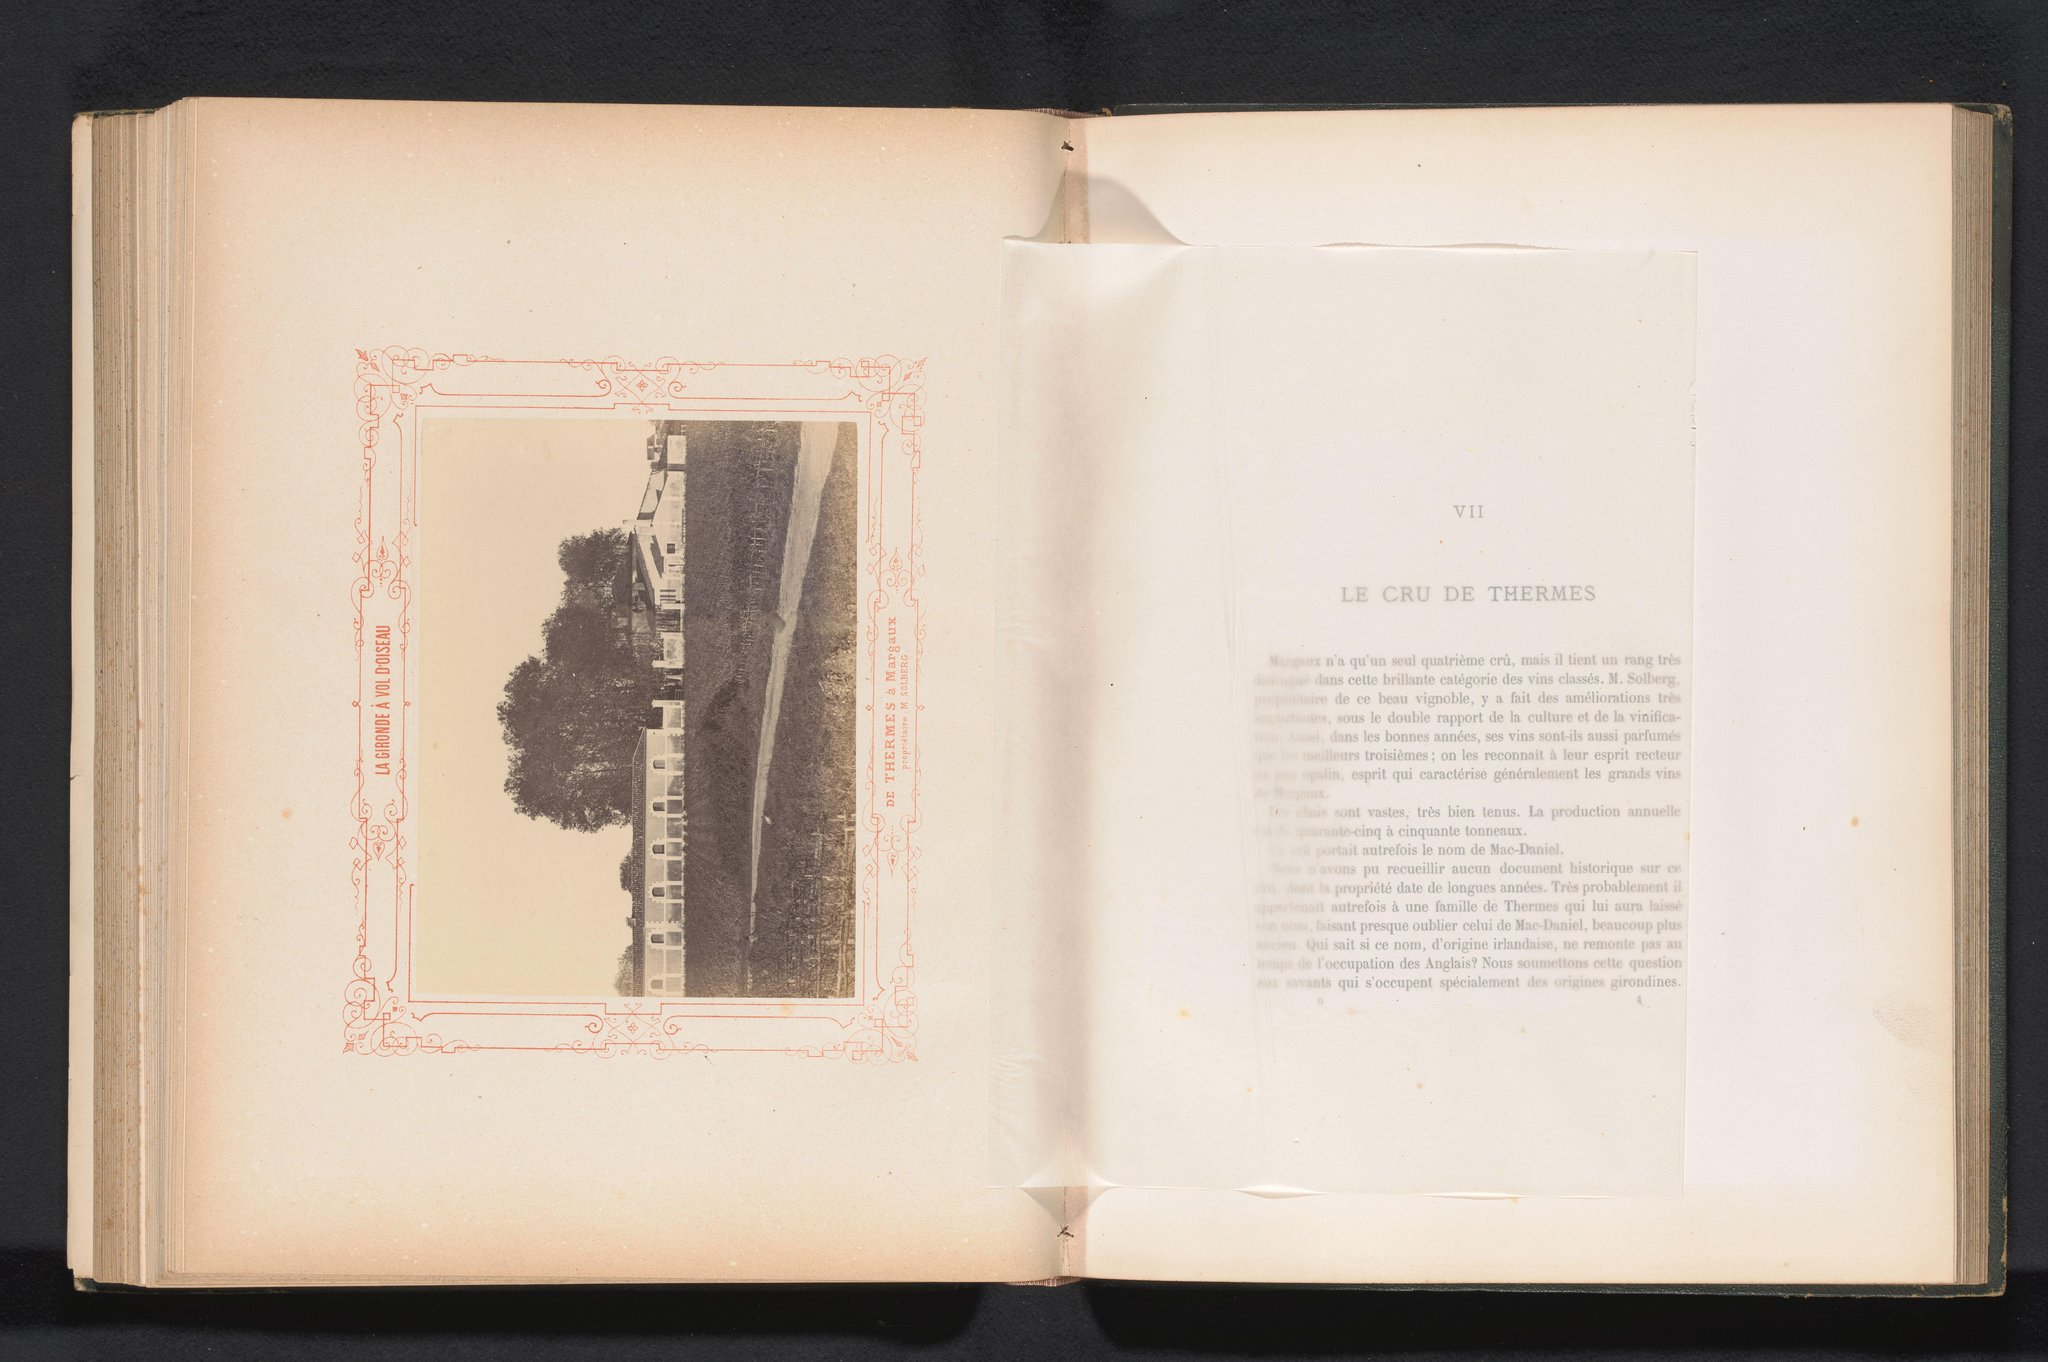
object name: page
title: De Thermes à Margaux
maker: alfred danflou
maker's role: fotograaf, schrijver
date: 1862-1867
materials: photographic support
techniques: albumen print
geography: margaux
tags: castle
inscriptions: inscription: ‘Propriétaire: M. SOLBERG.’